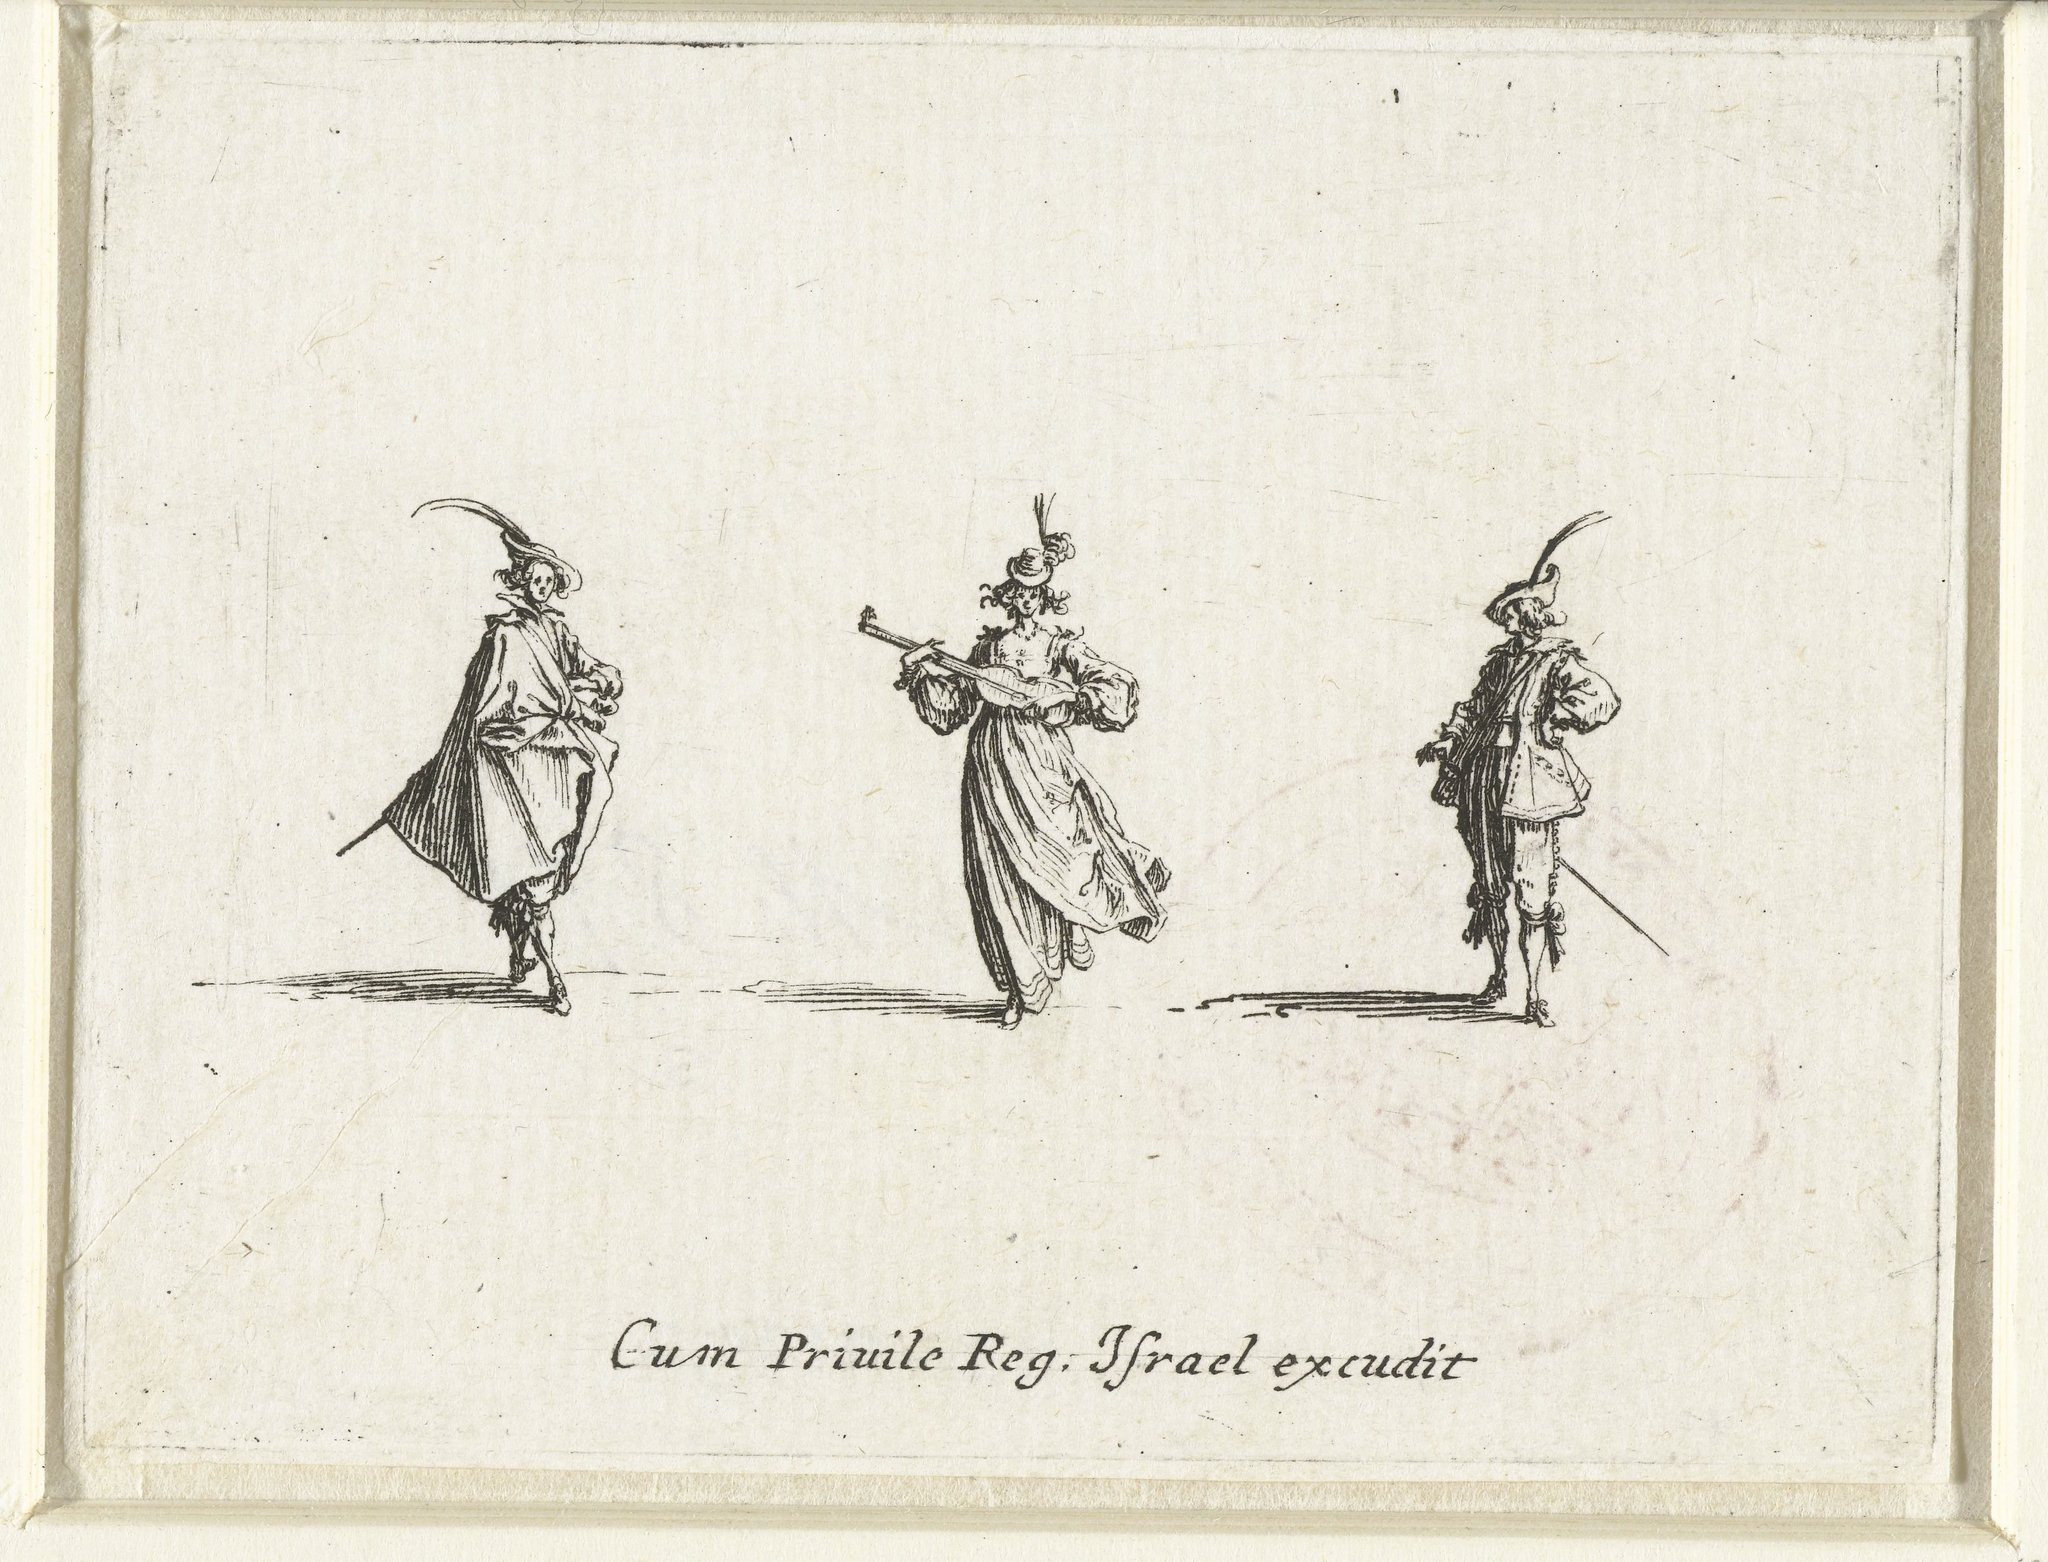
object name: costume print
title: Les Fantasies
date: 1633-1635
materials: paper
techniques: etching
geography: paris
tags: clothes, costume (+ women's clothes), clothes, costume (+ men's clothes), one person playing string instrument (plucked), cithern, mandolin, guitar, balalaika, france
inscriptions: collector's mark: Lugt 240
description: Links een heer, min of meer op de rechterzijde gezien. In het midden een dame, gitaar spelend, van voren gezien. Rechts een heer, min of meer van voren gezien. Deze prent is onderdeel van een serie van 13 prenten (14 incl. titelprent) met telkens drie figuren naast elkaar. Op elf prenten staan twee heren om één dame, op één prent staan drie heren en op één prent staan drie vrouwen. Mogelijk zijn deze prenten bedoeld geweest als tekenvoorbeelden.